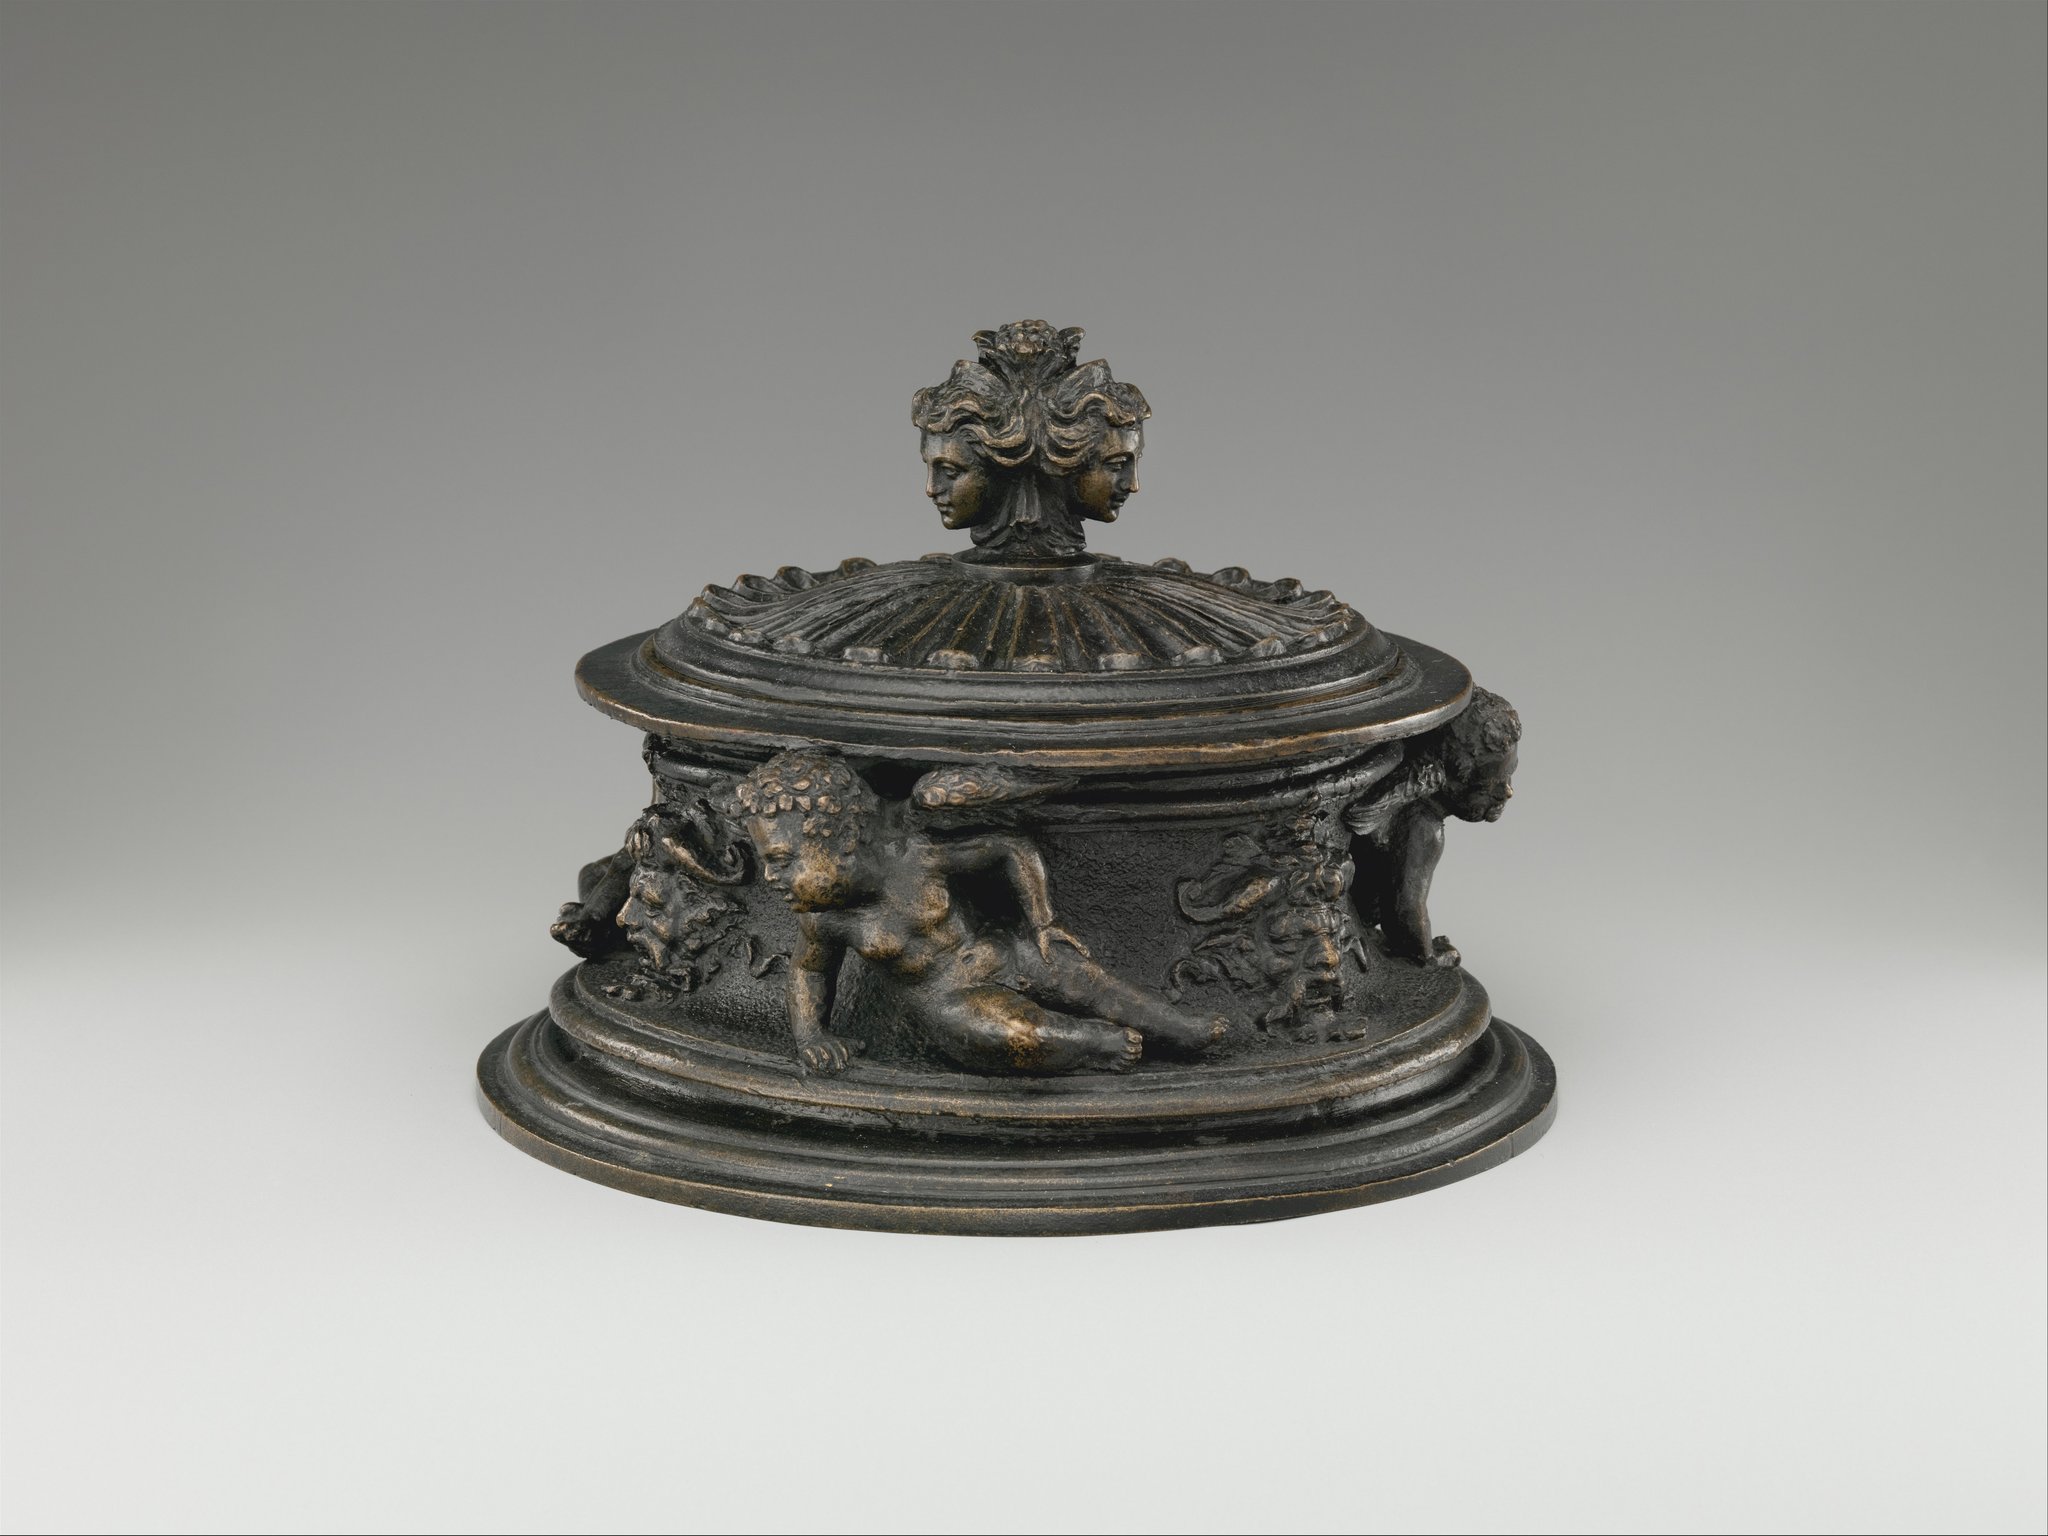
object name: bowl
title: Cylindrical container with cover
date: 1535-1545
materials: bronze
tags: putti